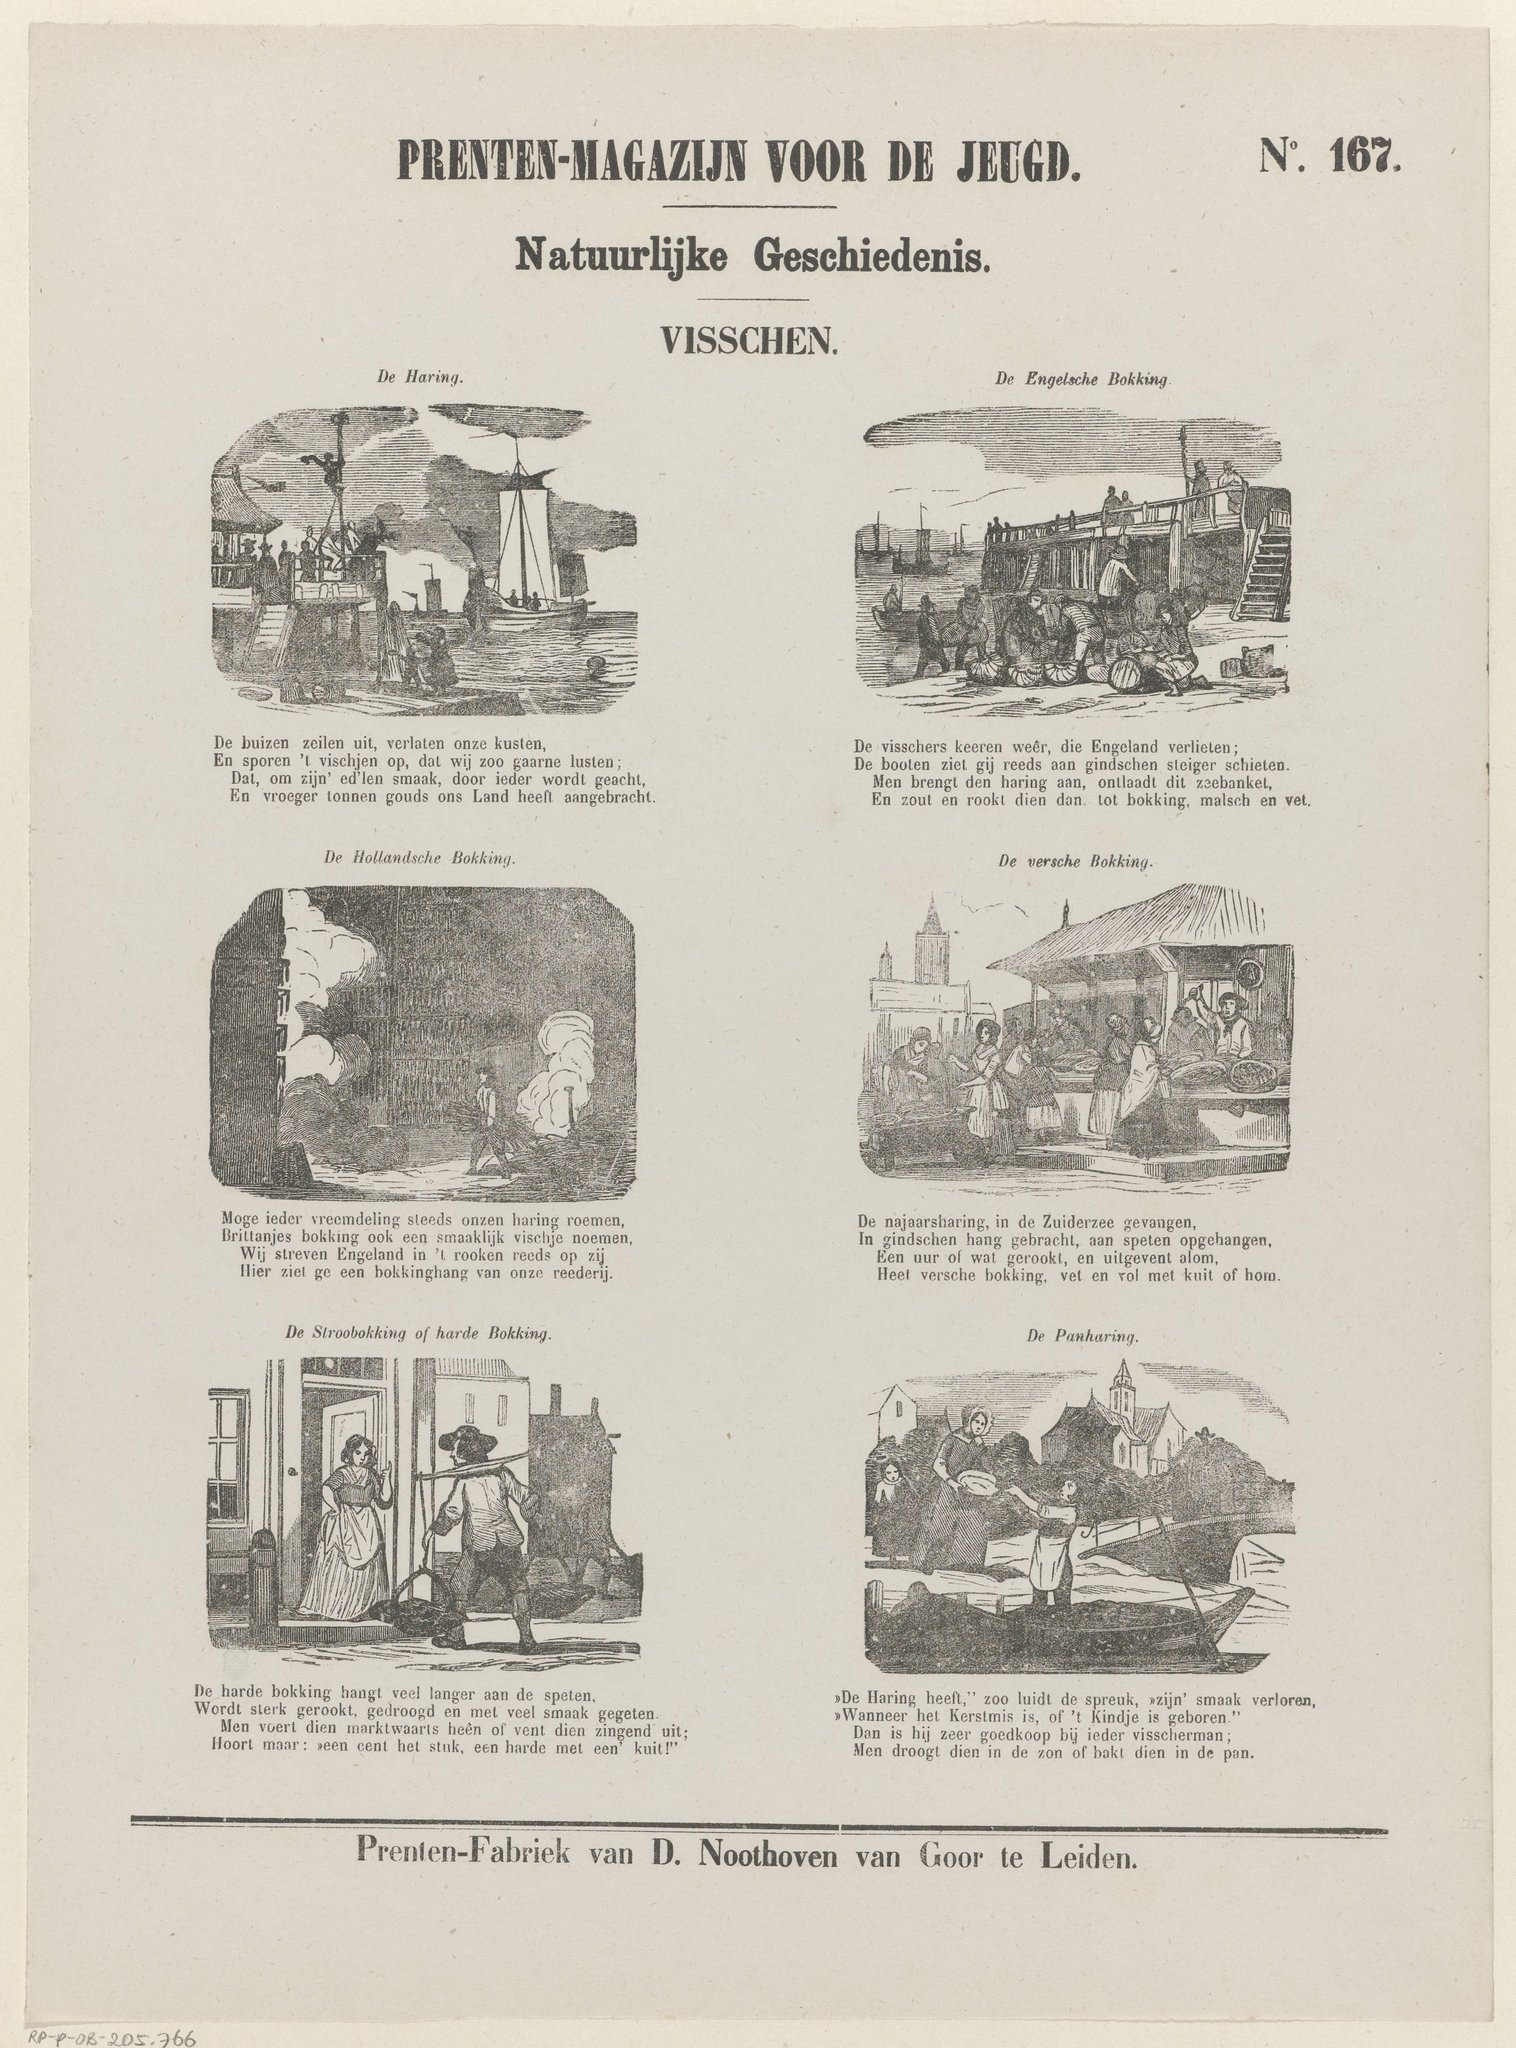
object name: popular print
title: Natuurlijke geschiedenis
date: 1850-1881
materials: paper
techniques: letterpress printing, engraving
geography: leiden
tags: commercial fishery, street-trader, merchant, salesman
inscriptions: collector's mark: Lugt 2760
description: Blad met 6 voorstellingen over het vangen en het verkopen van vis. Boven elke voorstelling een titel en onder elke voorstelling een vierregelig vers. Genummerd rechtsboven: No. 167.